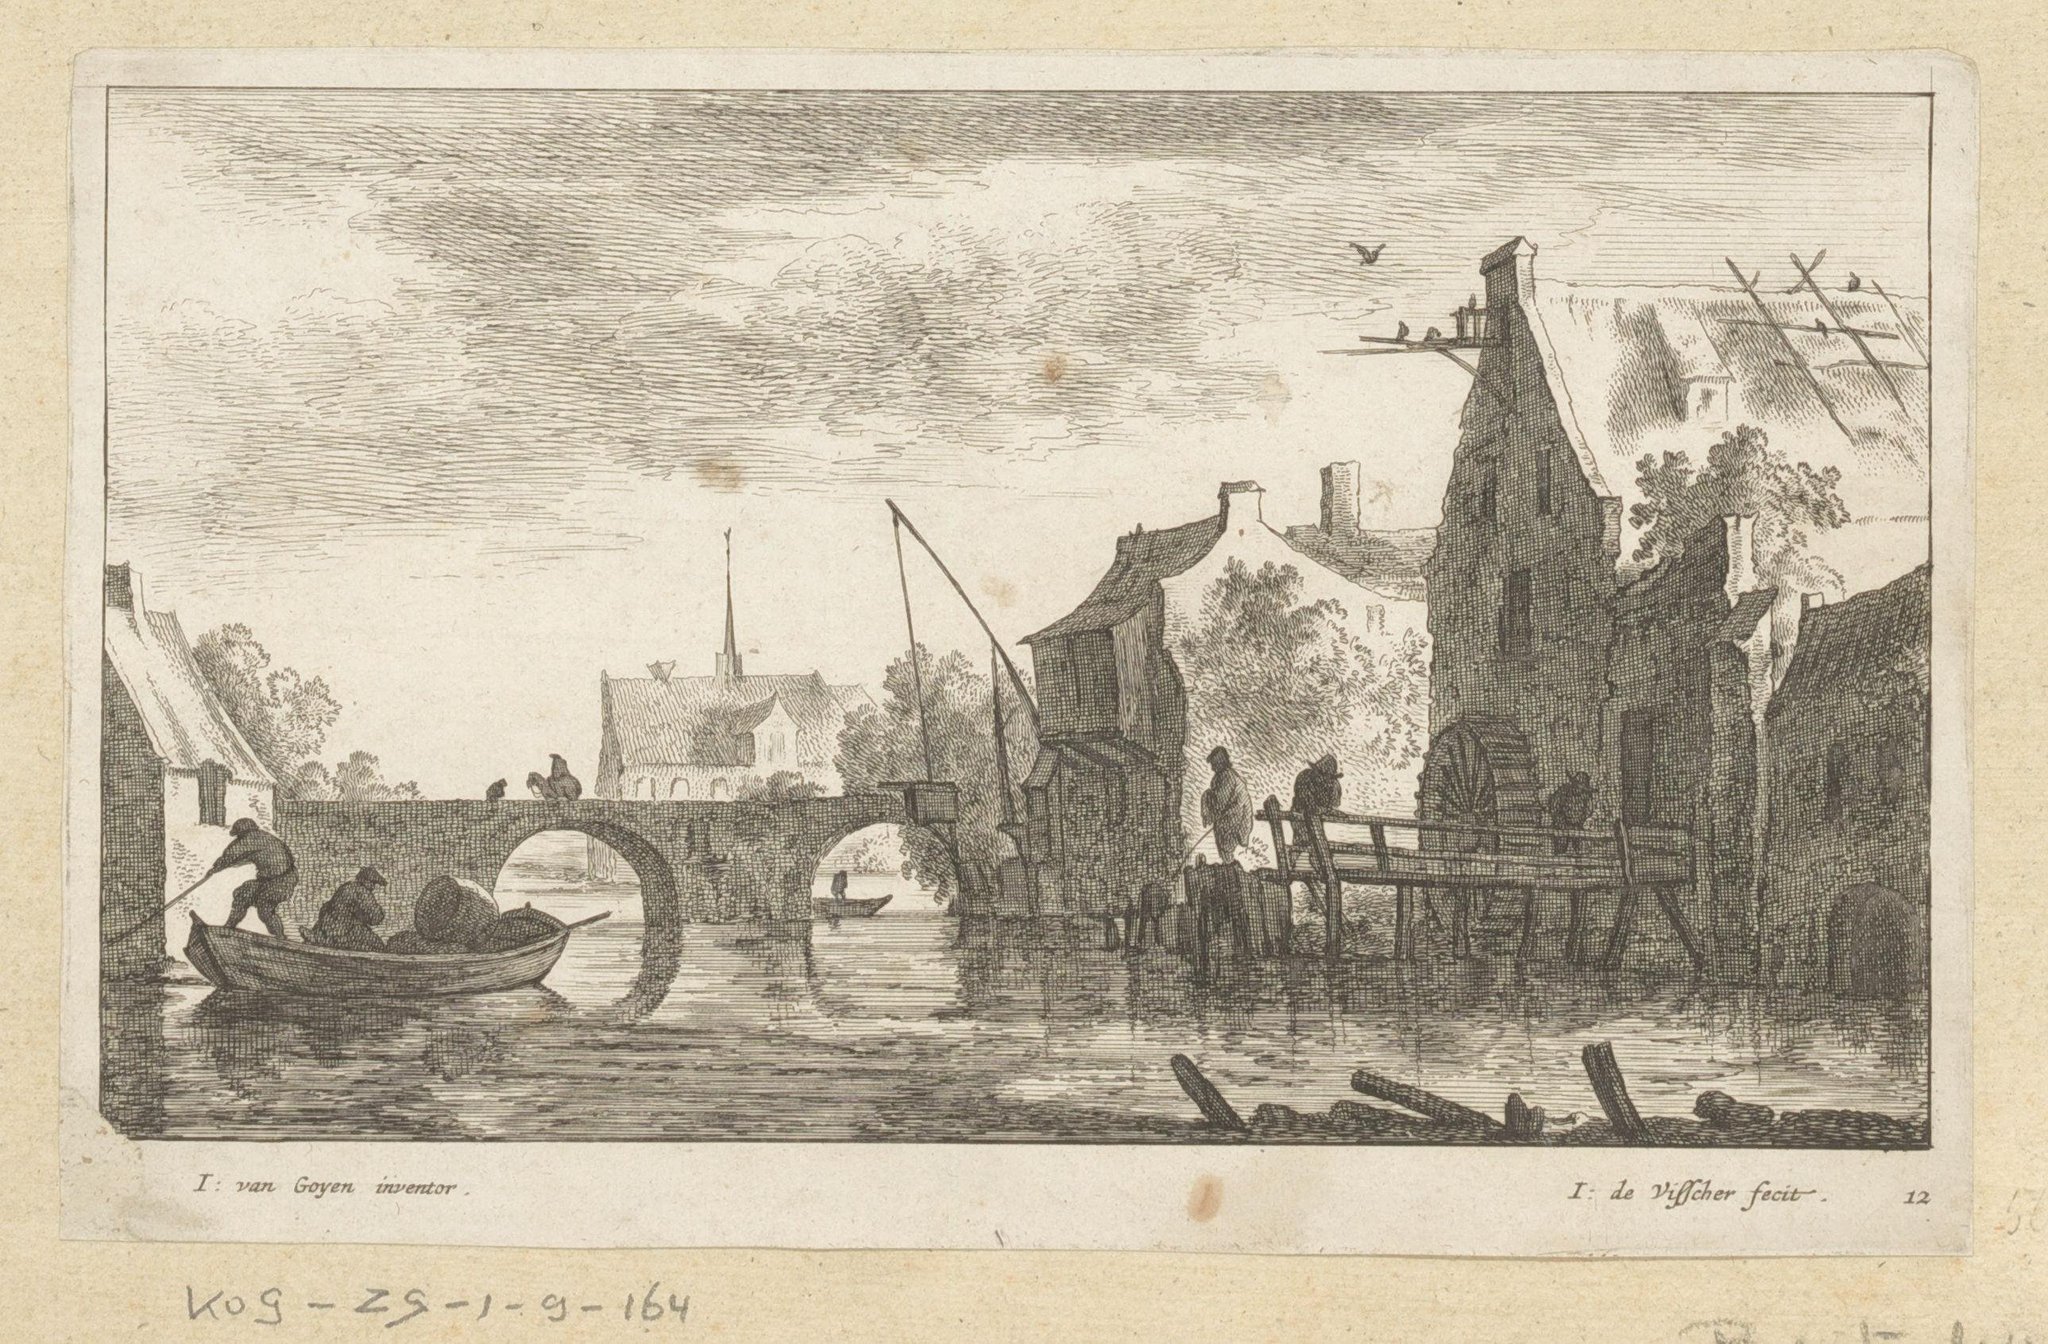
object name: print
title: Kerk aan een rivier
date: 1682-1709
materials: paper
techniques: engraving, etching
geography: amsterdam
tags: river, church (exterior), watermill in landscape, bridge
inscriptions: collector's mark: Lugt 1641, stamp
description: Gezicht op een rivier in een stad met rechts een watermolen. Op de achtergrond een brug en een kerk. Onderwerpsrubrieken binnen de Atlas Zeden en Gewoonten: Handel, nijverheid en verkeer, Buitenleven.